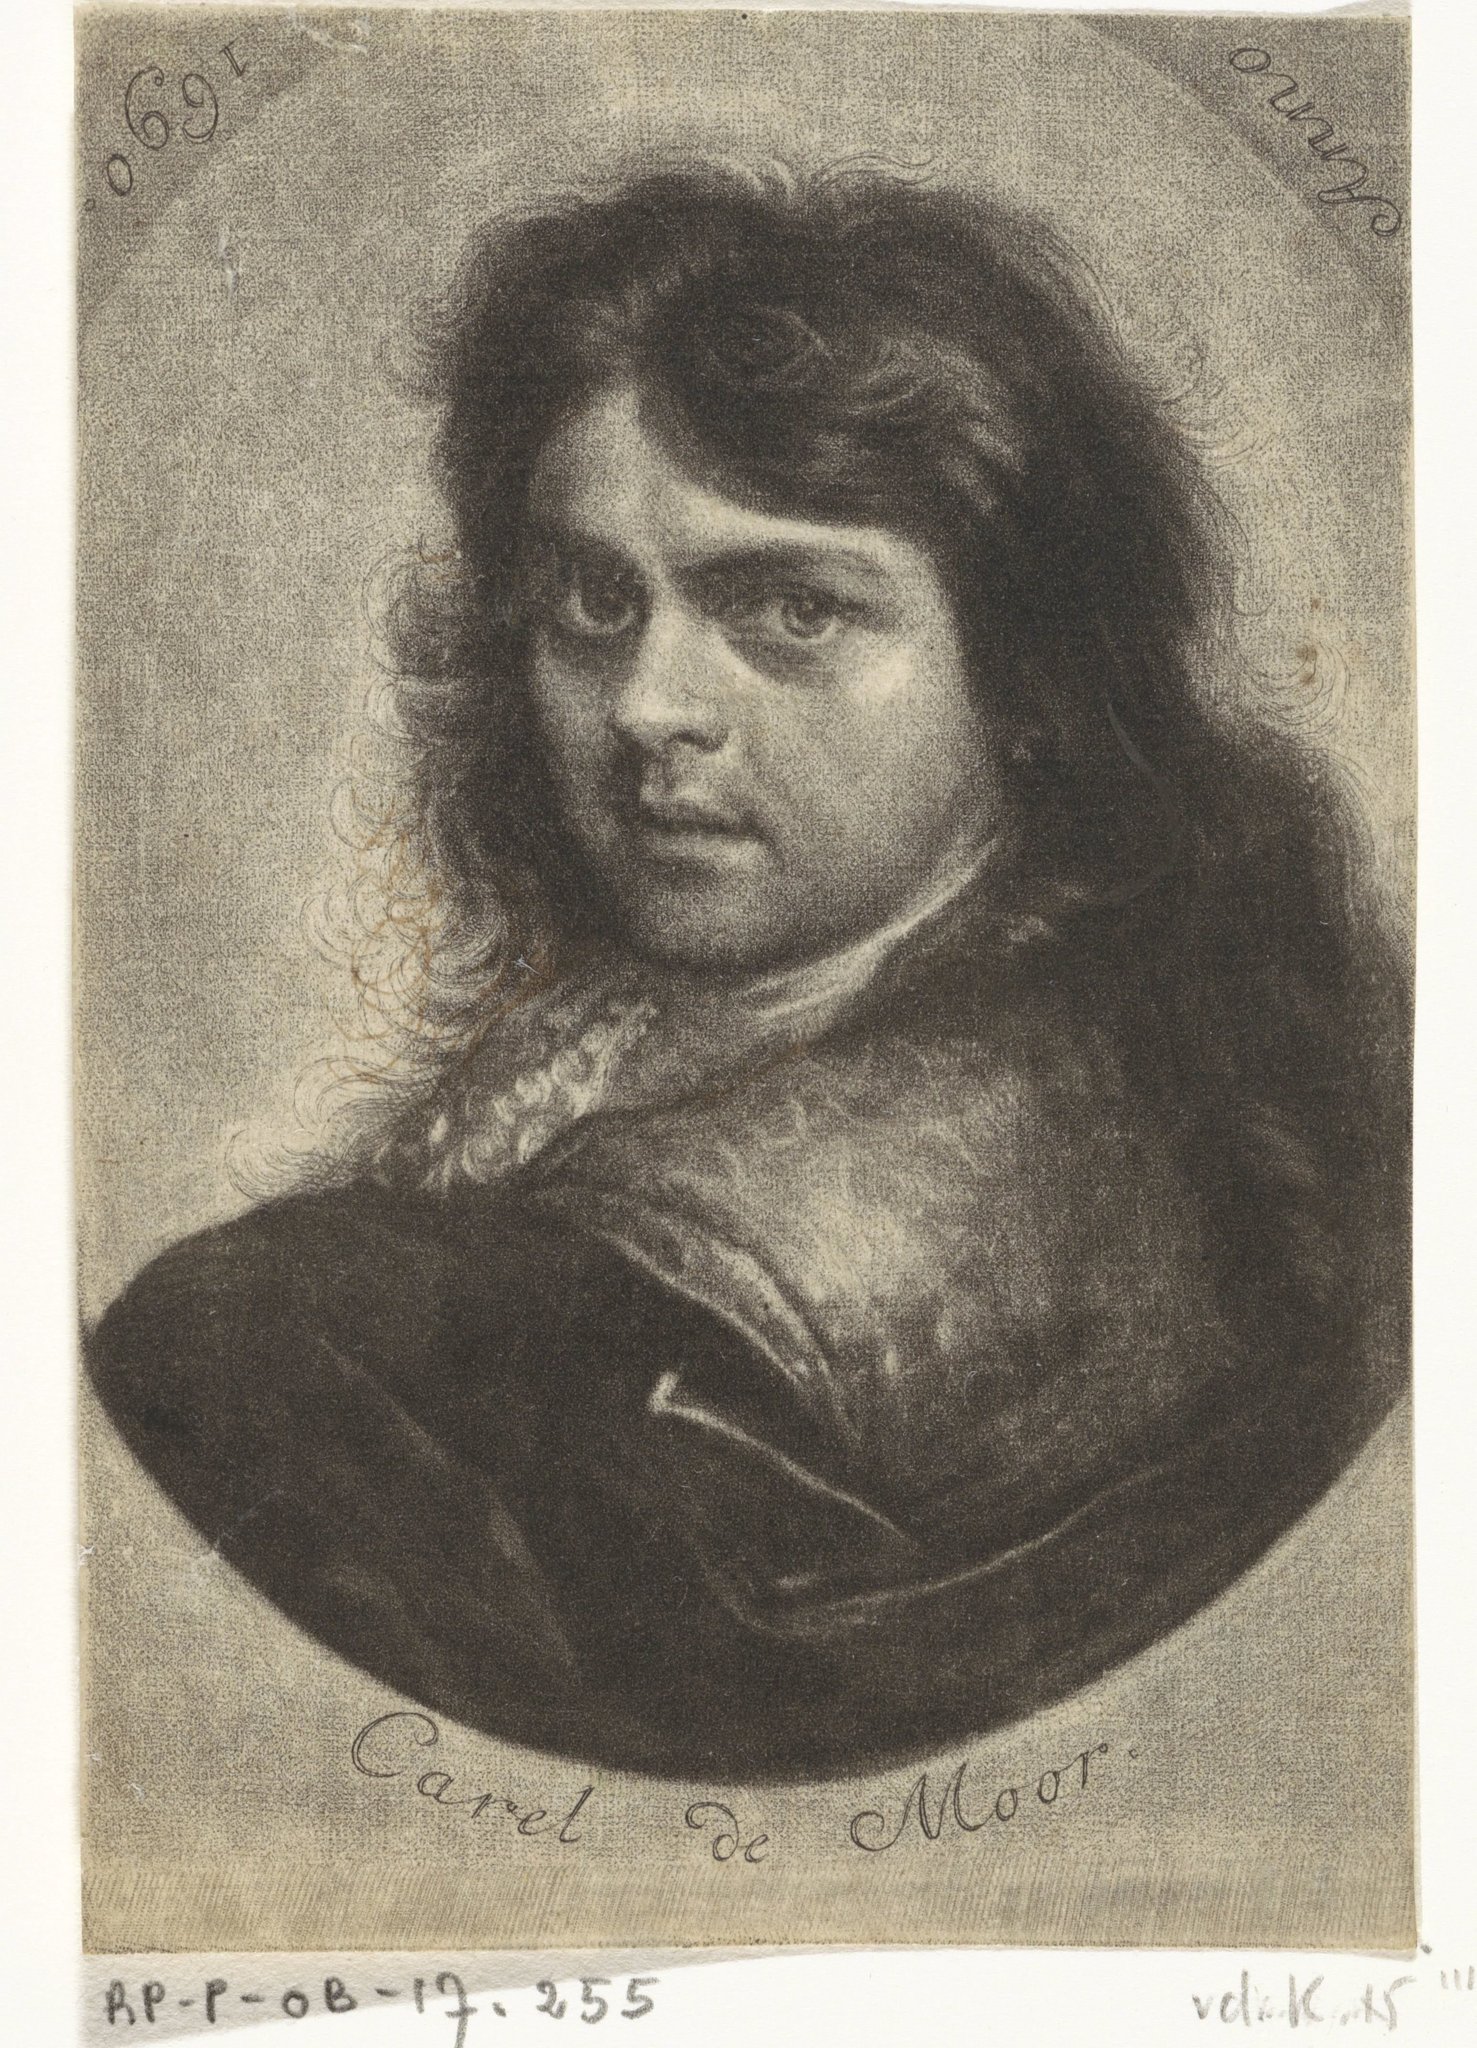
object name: print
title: Zelfportret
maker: carel de moor (ii)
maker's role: draughtsman, painter, print maker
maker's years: 1655-1738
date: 1690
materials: paper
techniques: engraving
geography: leiden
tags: leiden, warmond, painter, print maker, draughtsman, carel de moor (ii), portrait, self-portrait of graphic artist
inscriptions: collector's mark: Lugt 2228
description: De schilder, prentmaker en tekenaar Carel de Moor, op 34-jarige leeftijd.